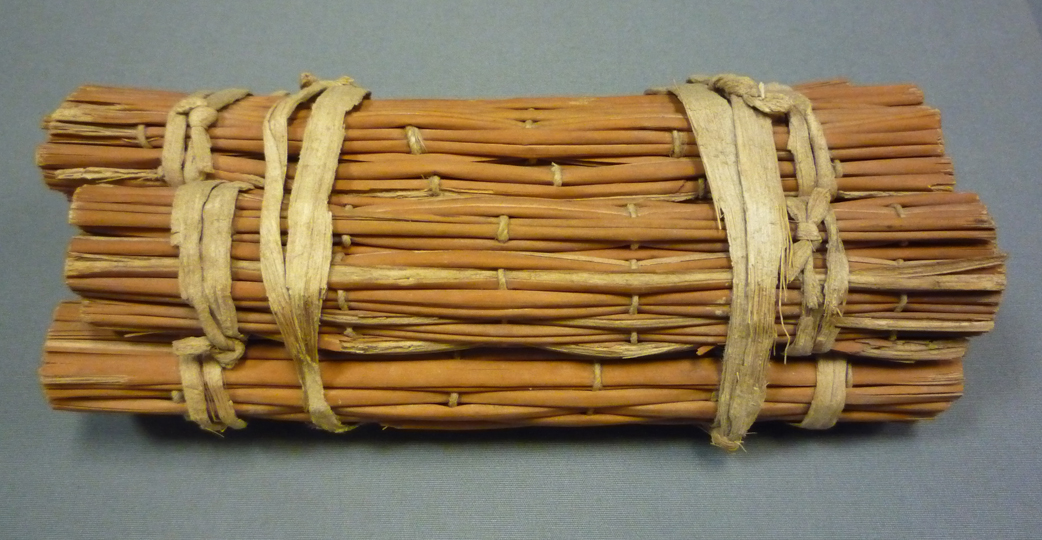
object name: mat, model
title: Bundle of Model Mats from the Foundation Deposit for Hatshepsut's Tomb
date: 1479-1458 BCE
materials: fiber, papyrus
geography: egypt